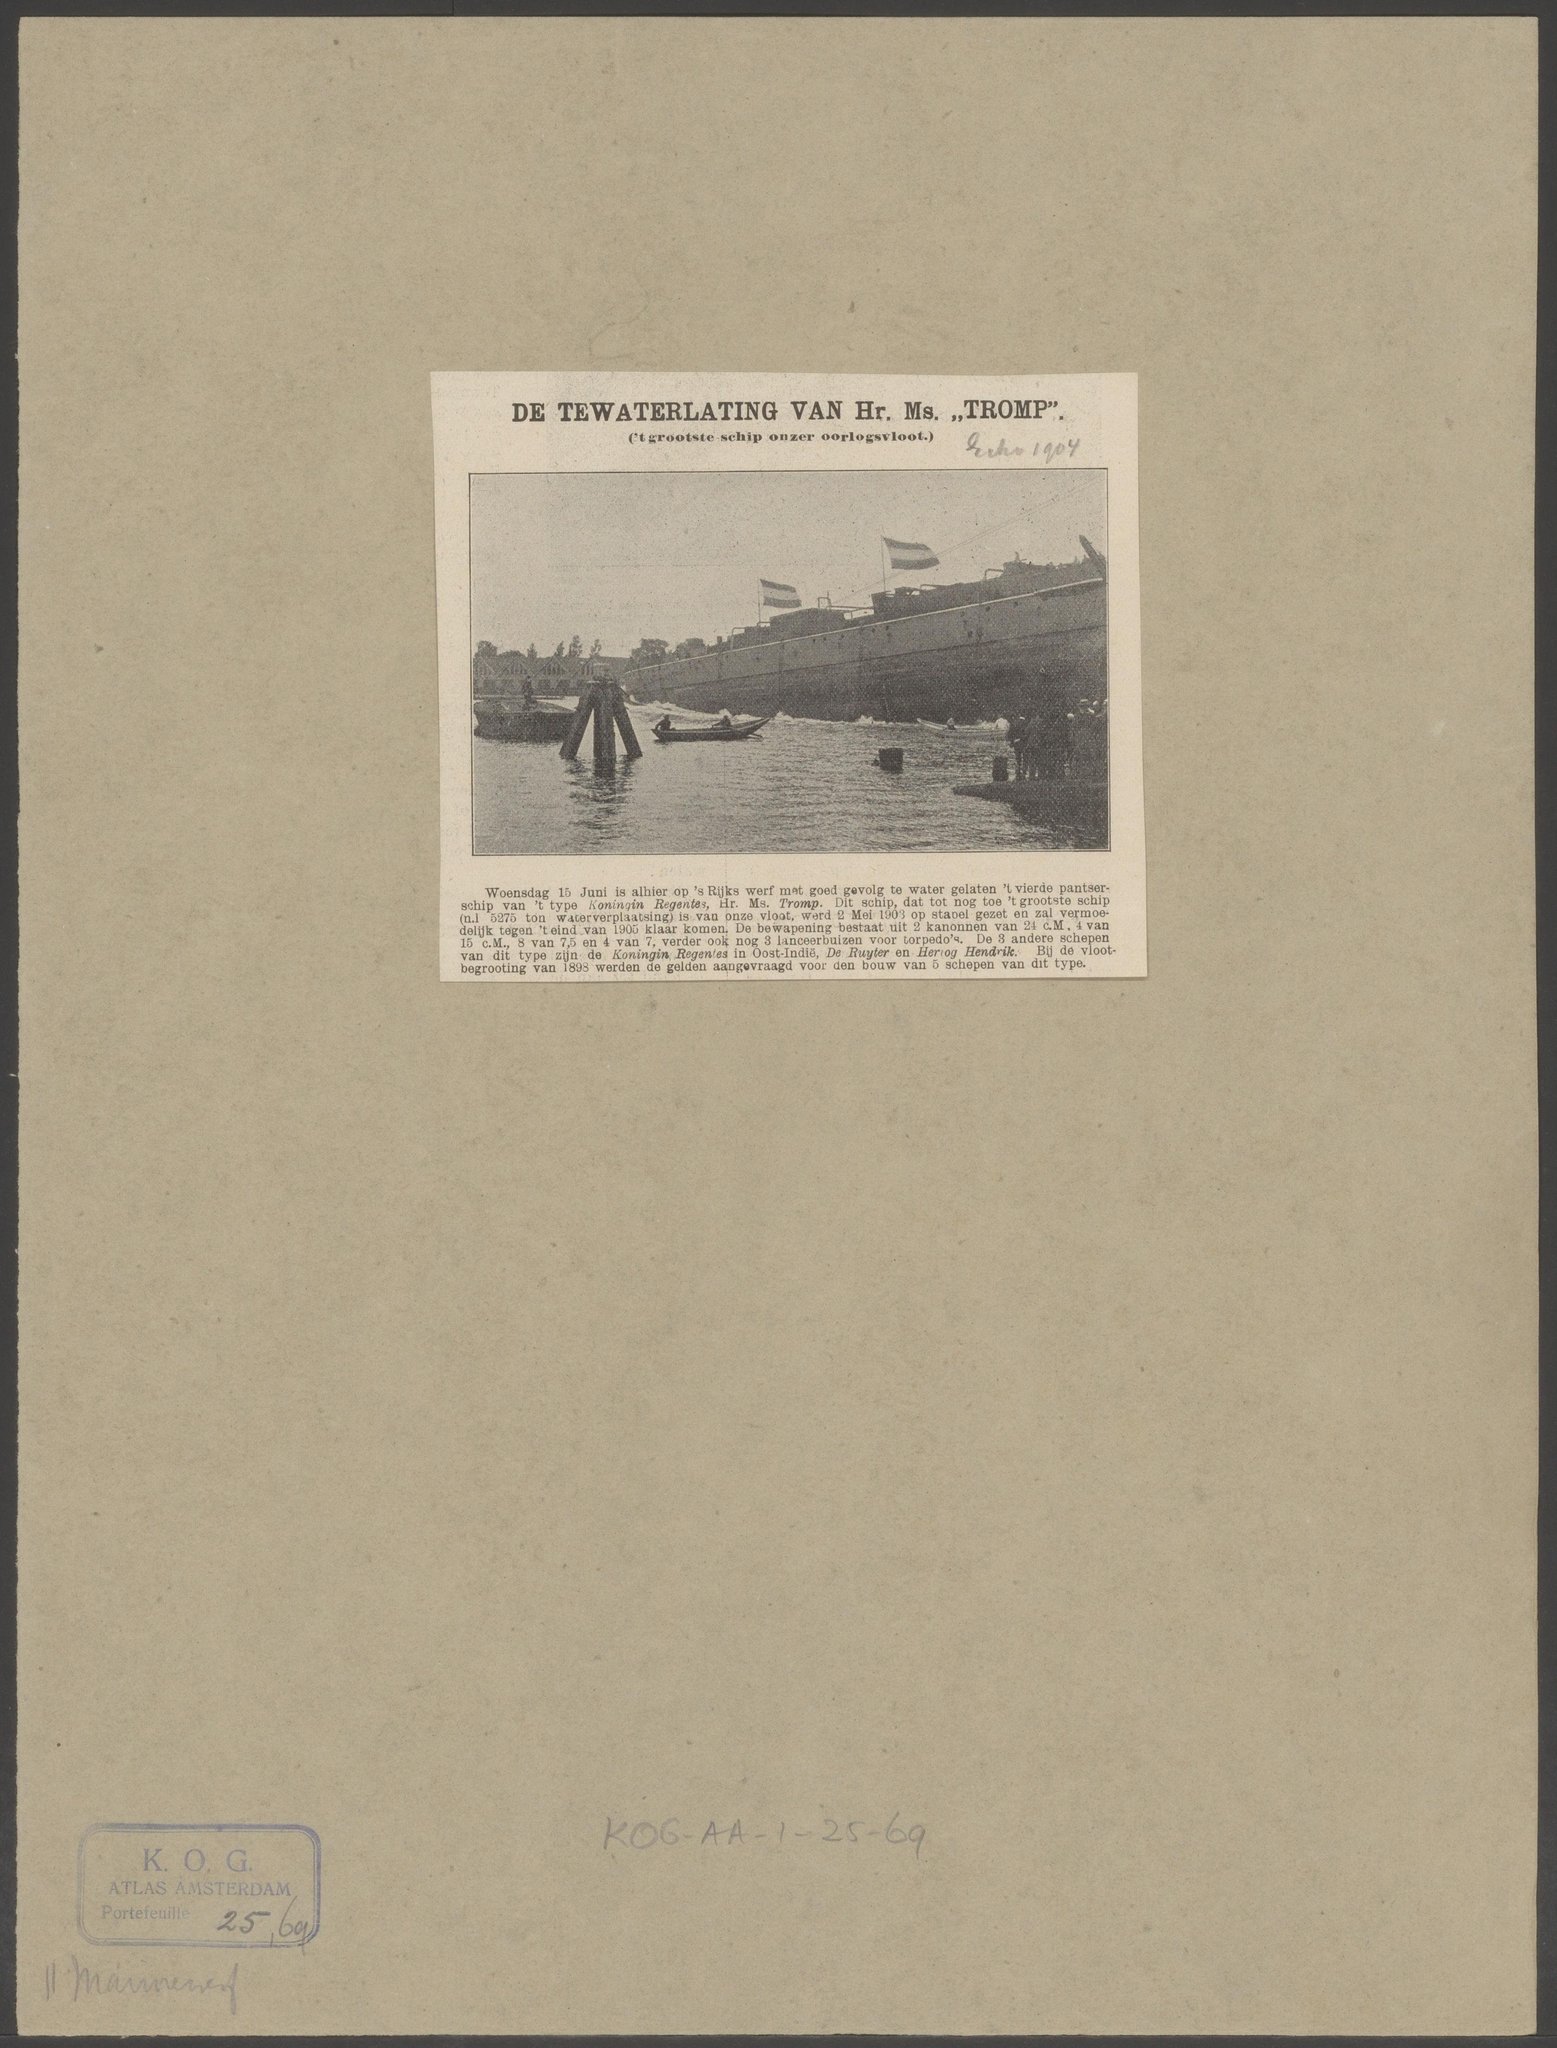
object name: photomechanical print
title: De tewaterlating van Hr. Ms. "Tromp"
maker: Anonymous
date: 1904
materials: paper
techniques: letterpress printing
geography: amsterdam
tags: large-scale structure for storage, e.g.: warehouse, depot, silo, launching a ship, ammunition store, arsenal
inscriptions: collector's mark: ‘25.69’ Lugt 1641b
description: Onderwerpsrubriek binnen de Atlas Amsterdam: Krijgswezen I: De Admiraliteit van Amsterdam, A. Admiraliteitsgebouwen.